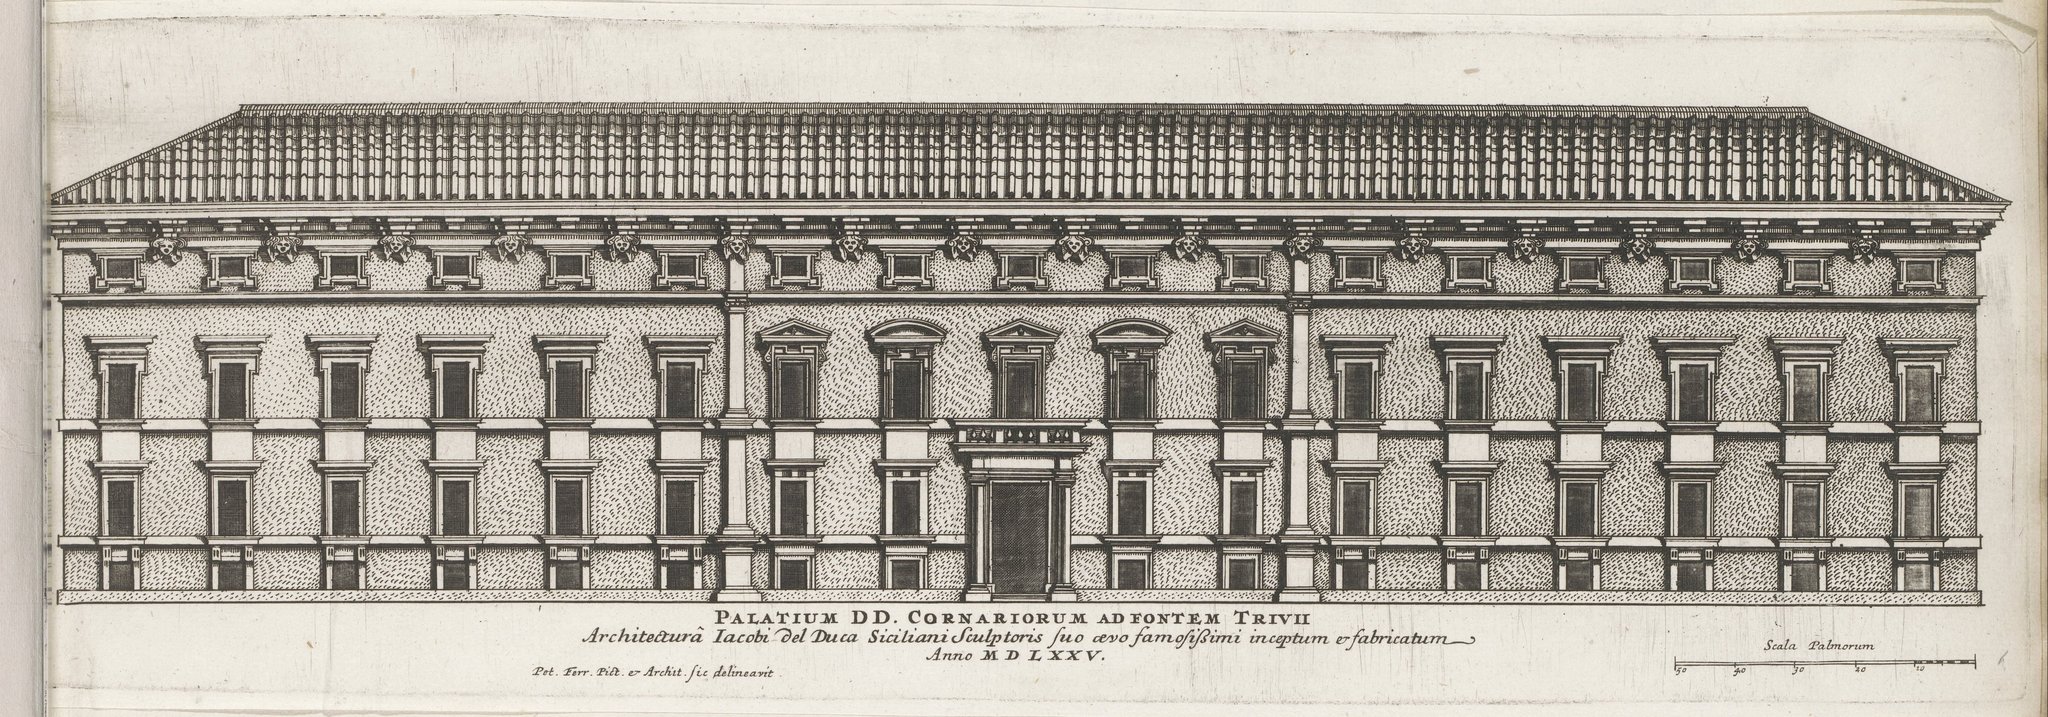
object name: print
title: Palatium D.D. Cornariorum ad fontem Trivii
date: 1655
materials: paper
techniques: etching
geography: rome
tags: palace, façade (of house or building)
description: Deze prent maakt deel uit van de reeks getiteld: Palazzi di Roma. Deze reeks bestaat uit twee boeken. Boek één getiteld: Palazzi di Roma dei più celebri architetti..., bestaat uit 44 prenten die worden toegeschreven aan Giovanni Battista Falda (naam staat enkel op prent 27) en uitgegeven door Giovanni Giacomo de'Rossi. Deze 44 prenten zijn bekend in twee staten (met en zonder nummer). Boek twee getiteld: Nuovi disegni dell'architetture... libro secondo, bevat 66 prenten door Giovanni Battista Falda en Simone Felice. Deze 66 prenten zijn bekend in twee staten (met en zonder nummer).